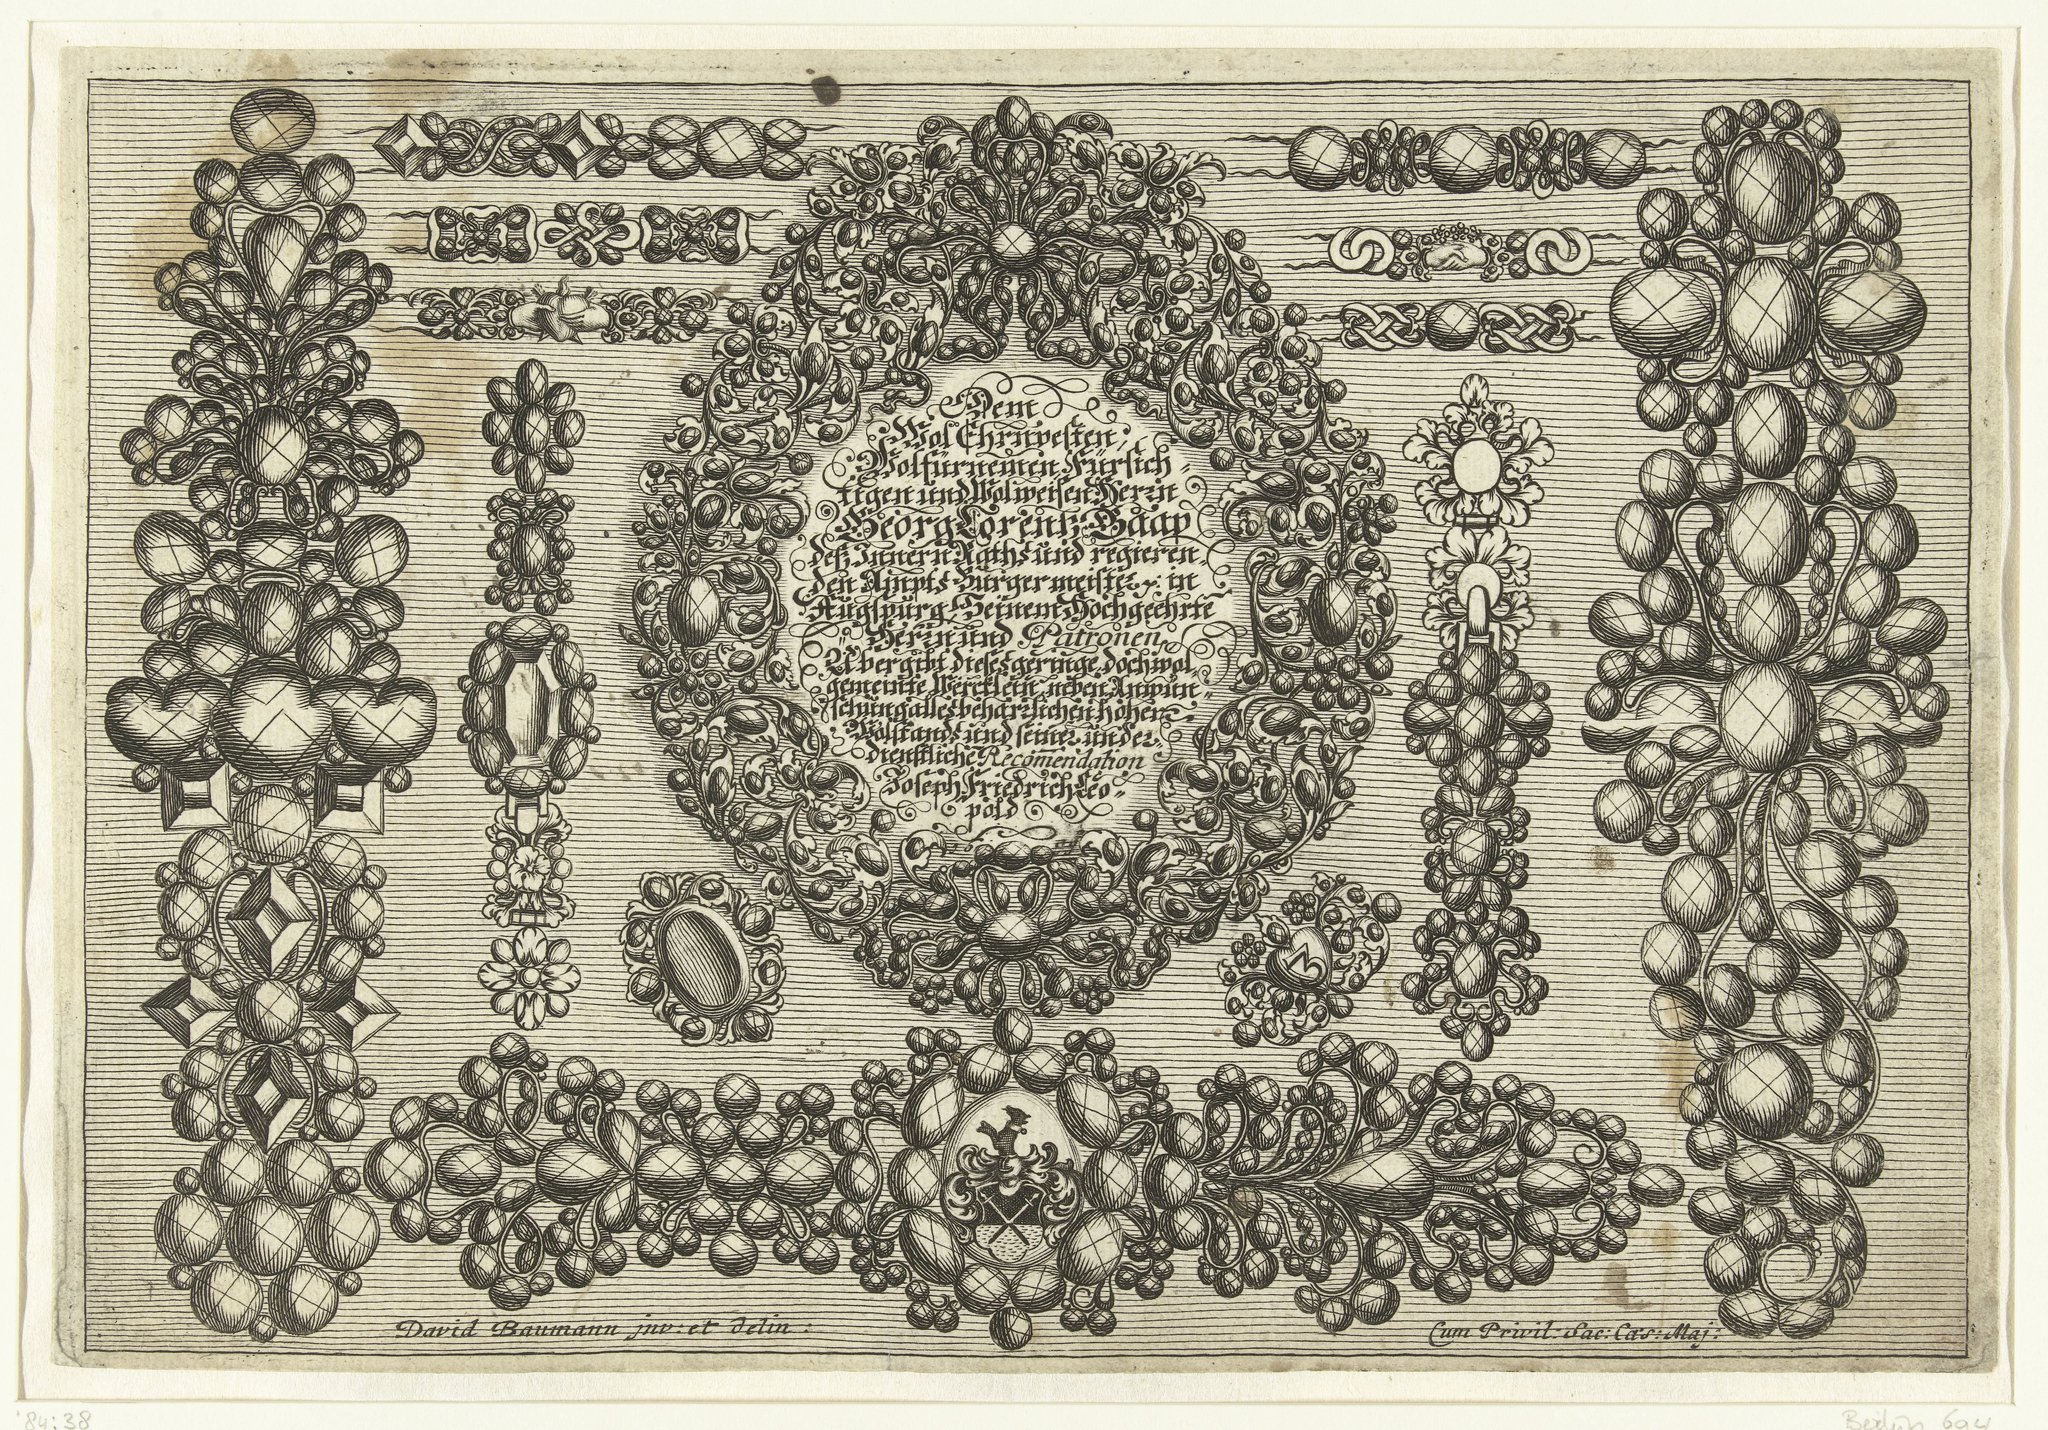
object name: print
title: Opdracht van uitgever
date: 1695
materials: paper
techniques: engraving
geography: germany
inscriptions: date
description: De opdracht is omringd door bladranken, gedecoreerd met diamanten. Blad 2 uit serie van 17 bladen.